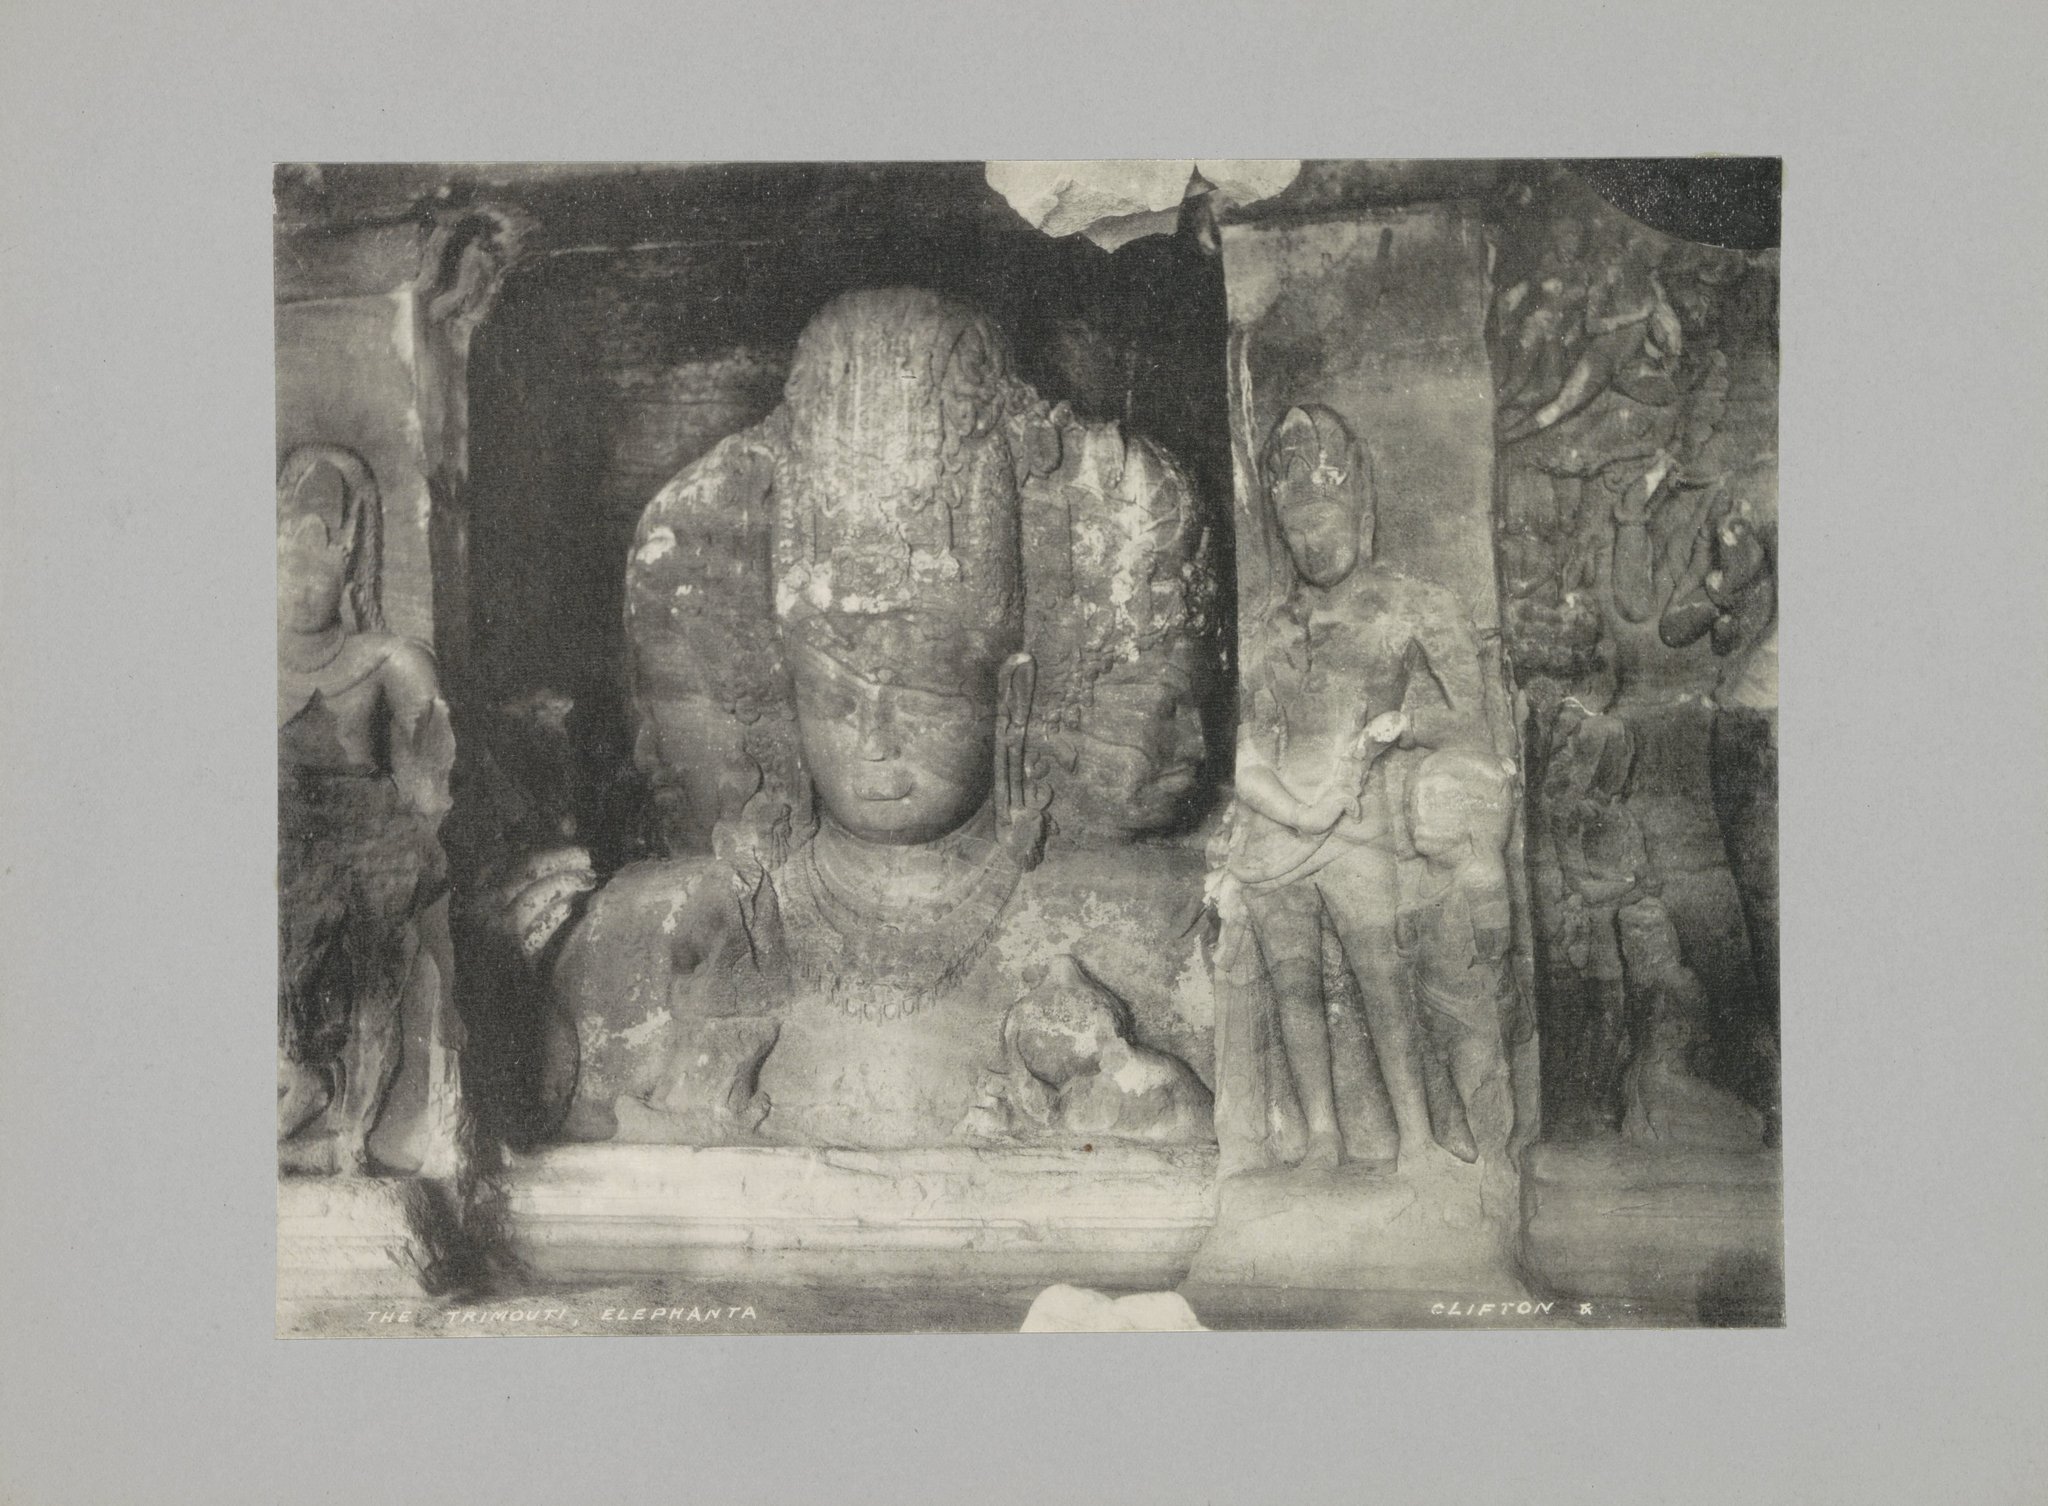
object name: photomechanical print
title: Maheshamurti sculpture in the Elephanta Caves near Mumbai, Maharashtra, India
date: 1895-1915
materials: cardboard, paper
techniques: photograph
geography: mumbai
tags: mumbai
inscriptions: annotation: ‘73. Elefanta.’, title: ‘THE TRIMURTI, ELEPHANTA’, signature: ‘CLIFTON &.’